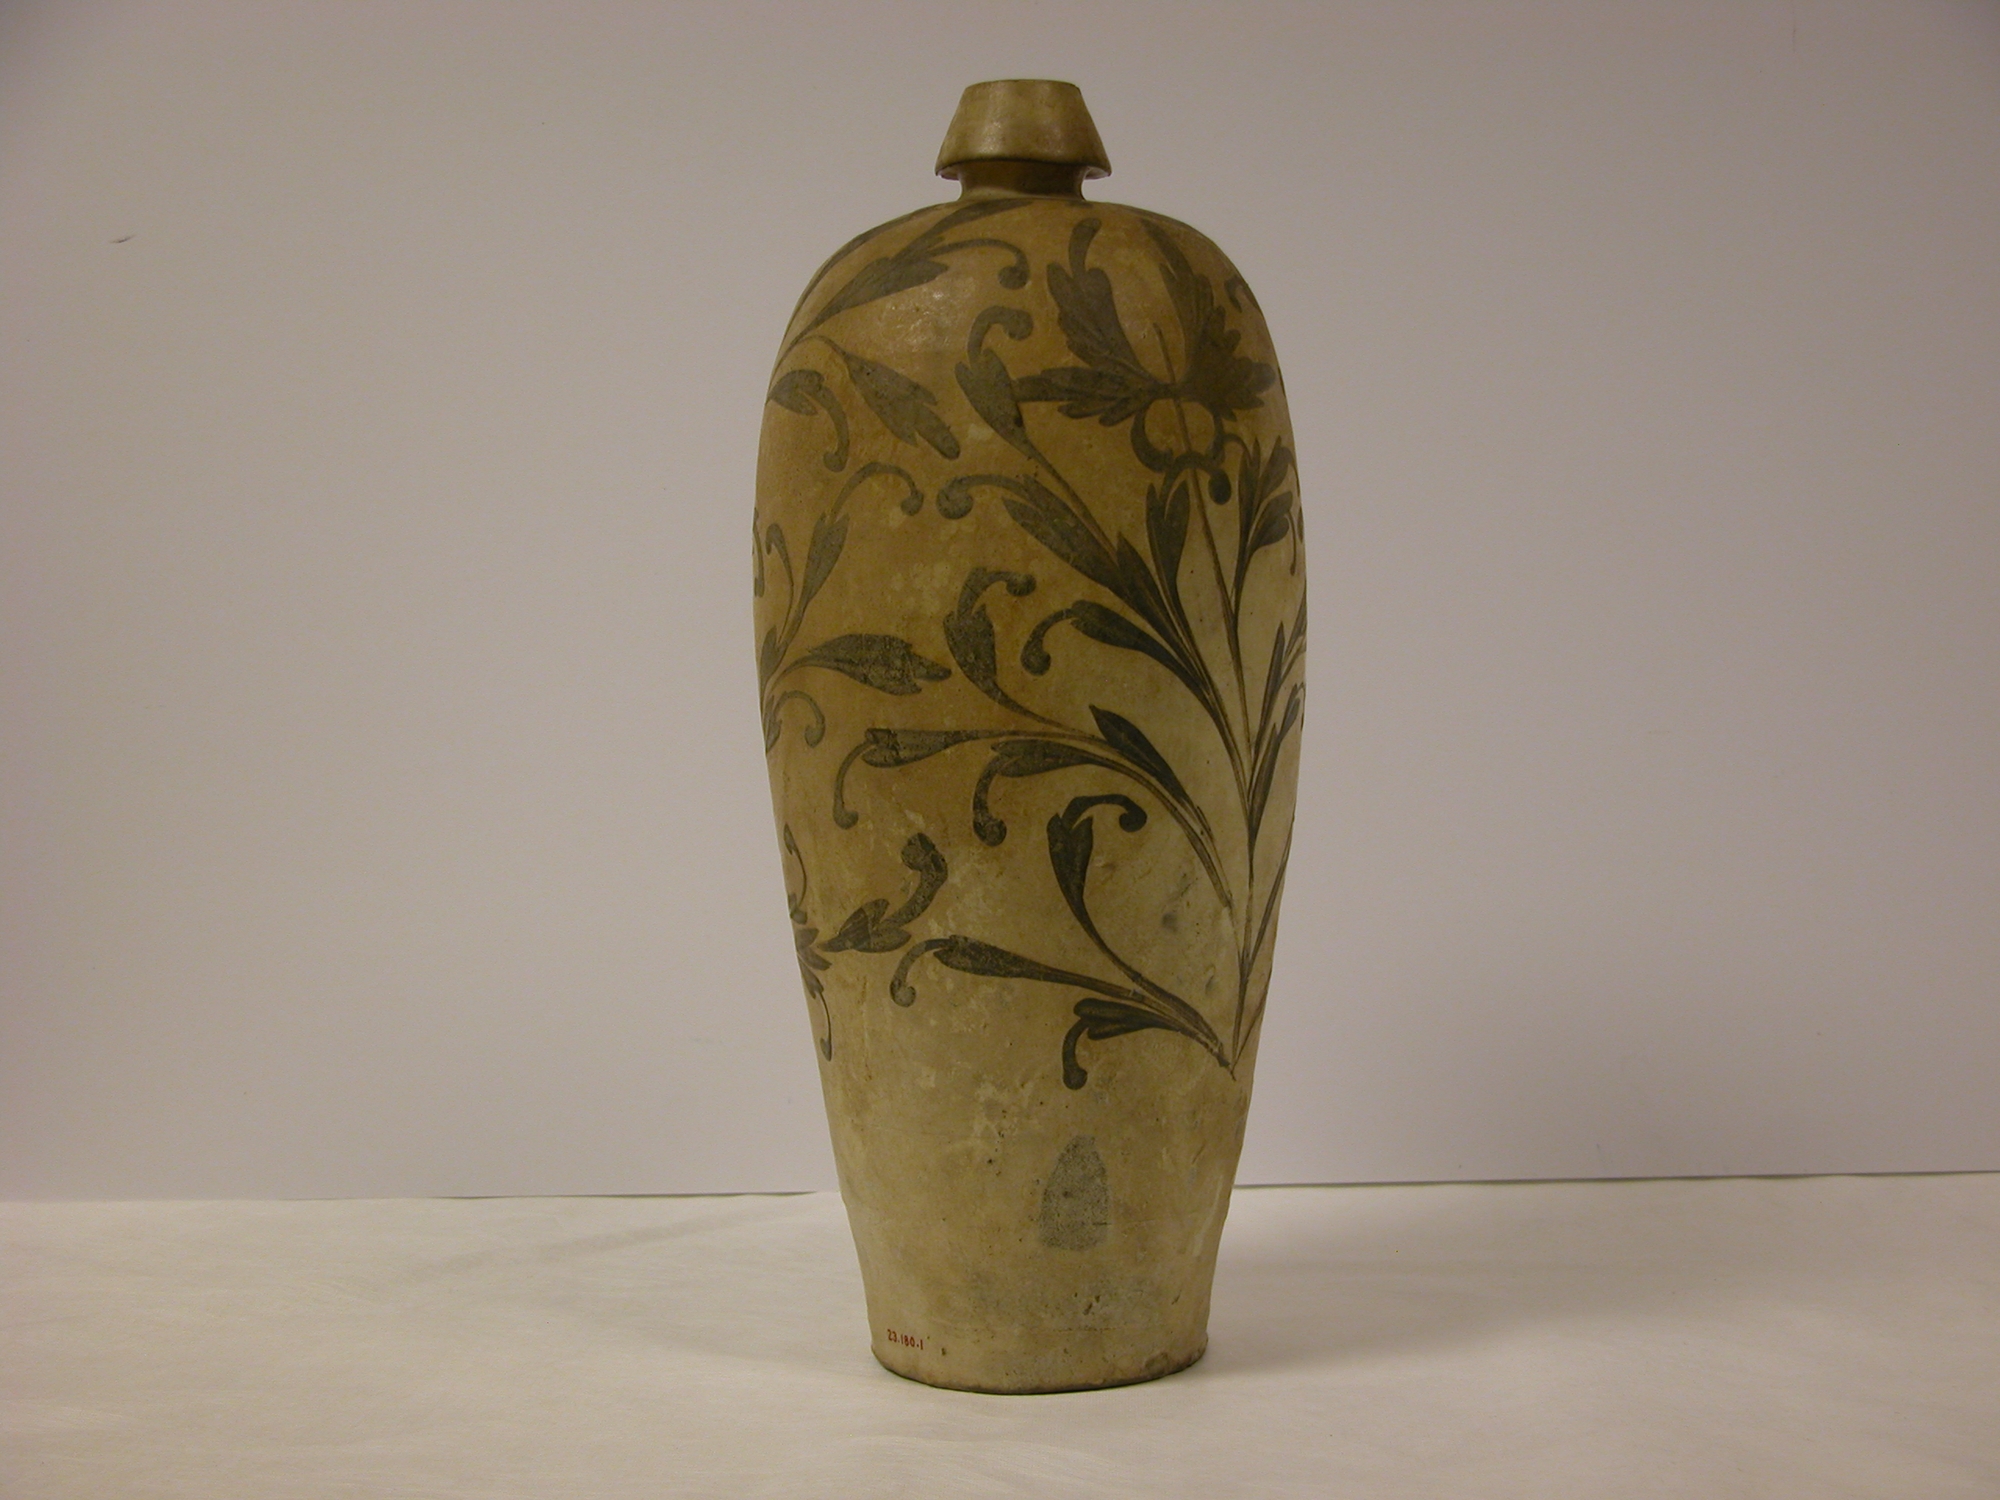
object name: vase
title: Meiping vase with flowers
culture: chinese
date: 1101-1300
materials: stoneware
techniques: painting